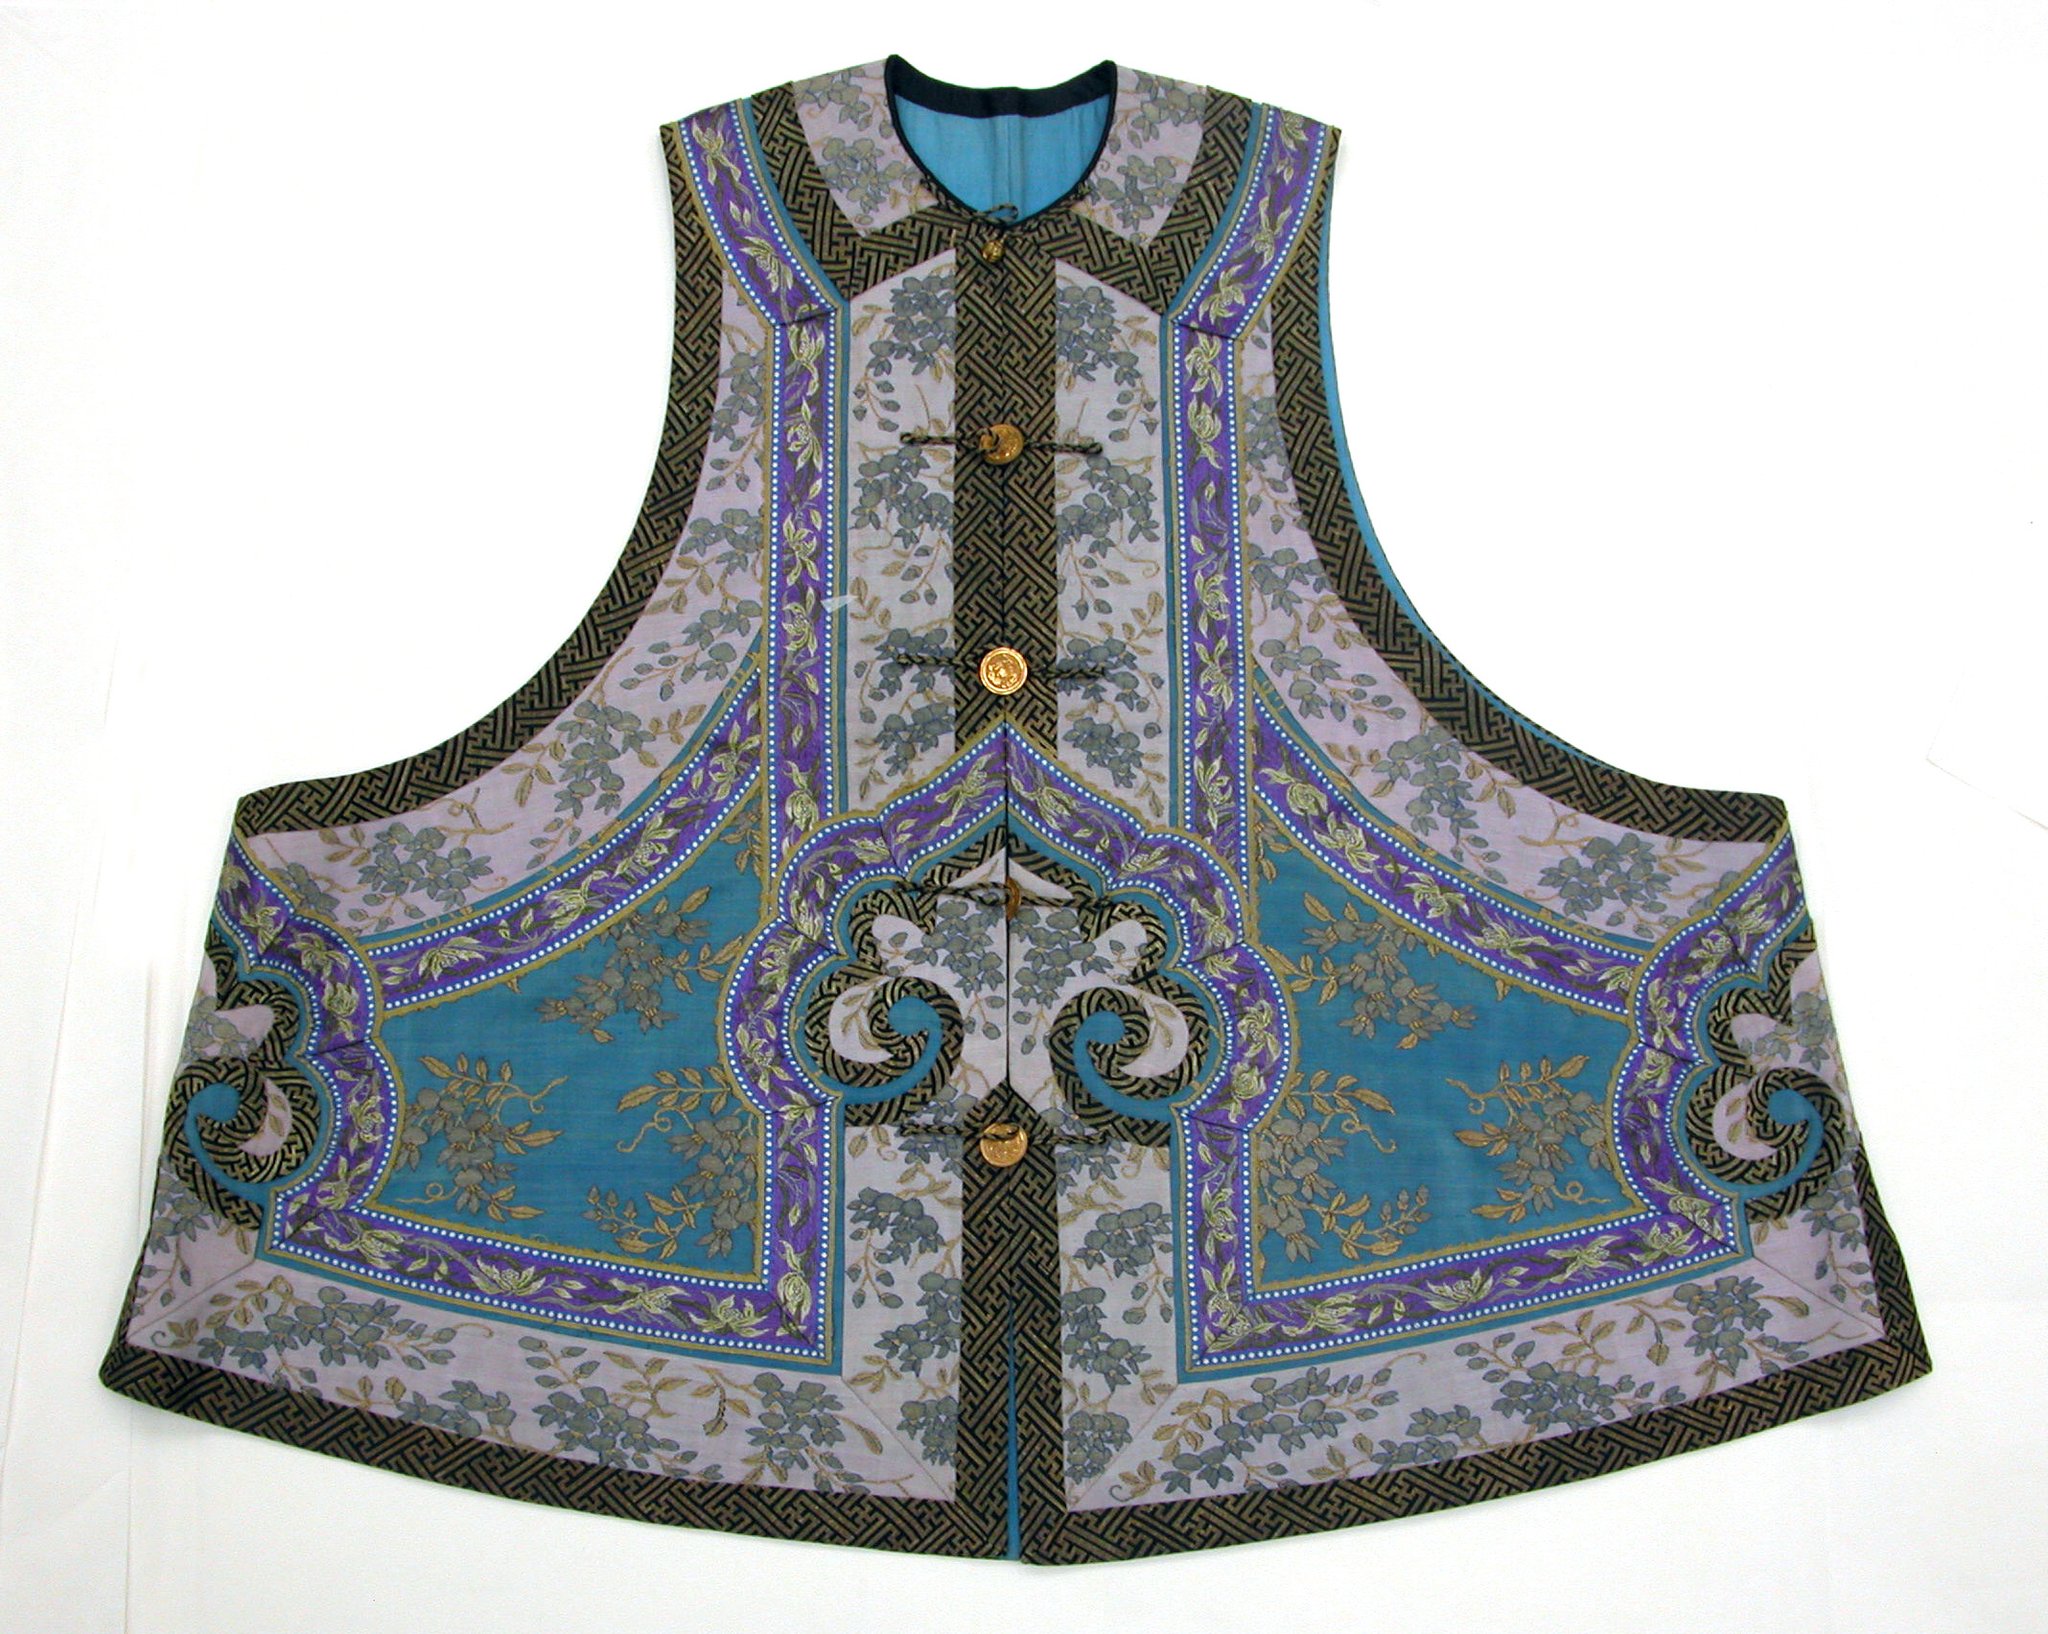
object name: woman's sleeveless jacket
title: Sleeveless Jacket with Flowering Vine Pattern and Bands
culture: chinese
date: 1867-1933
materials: silk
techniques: tapestry